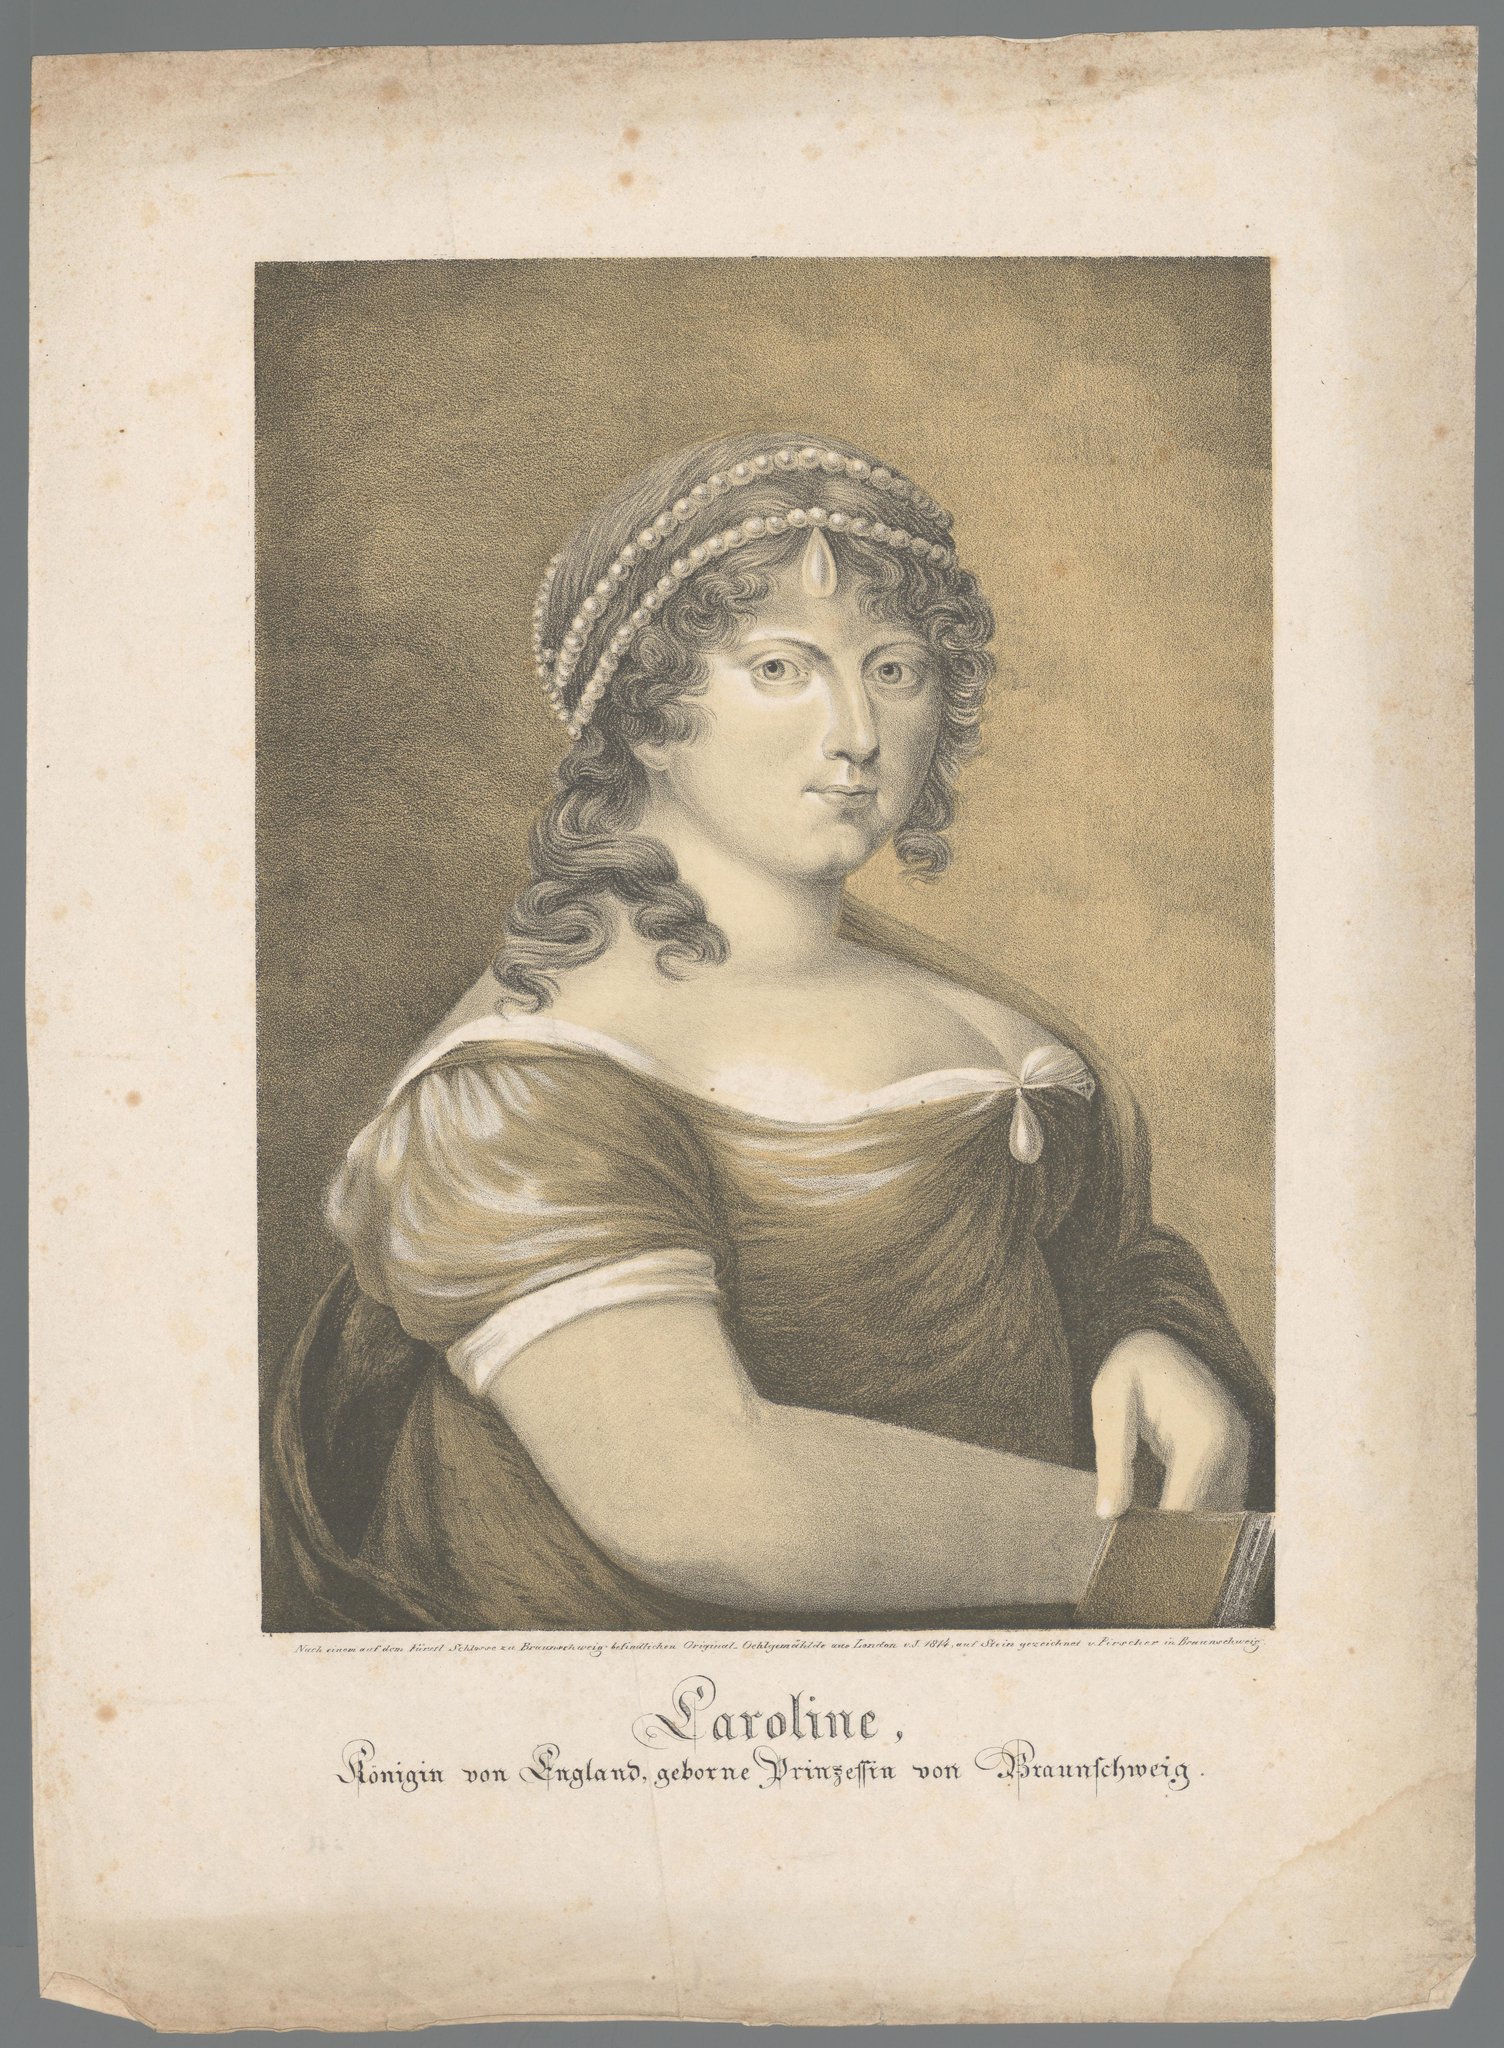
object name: print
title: Caroline, Königin von England, geborne Prinsessin von Braunschweig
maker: karl dietrich pirscher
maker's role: print maker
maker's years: 1791-1857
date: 1814-1857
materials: paper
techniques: tone lithography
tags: adult woman, historical persons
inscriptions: collector's mark: Lugt 2228